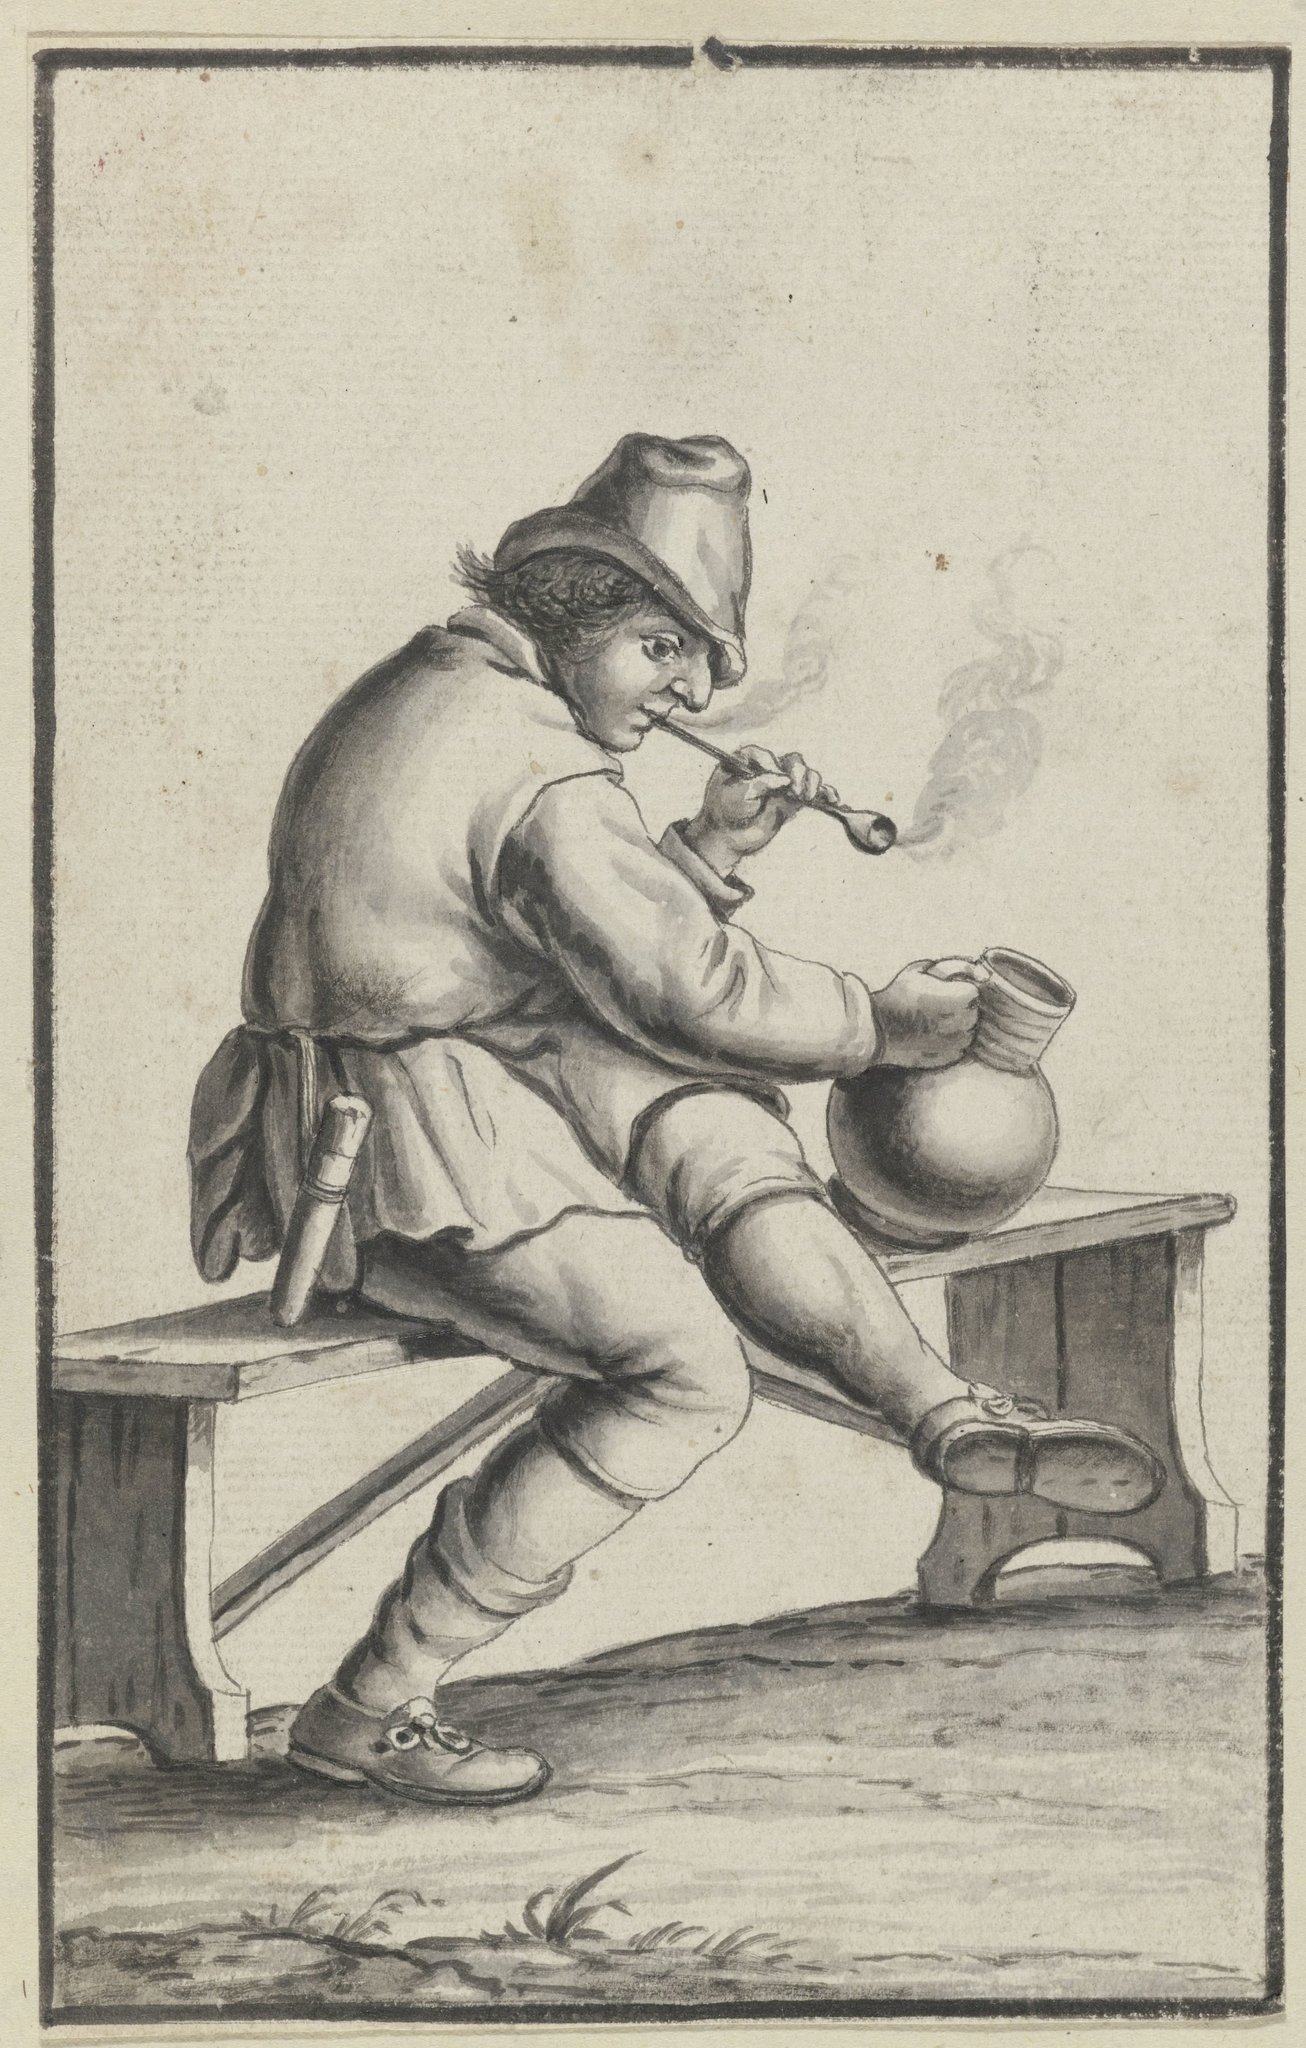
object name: drawing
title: Pijprokende man met kruik zittend op een houten bank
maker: Anonymous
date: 1700-1799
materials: ink, paper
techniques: brush, pen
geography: netherlands